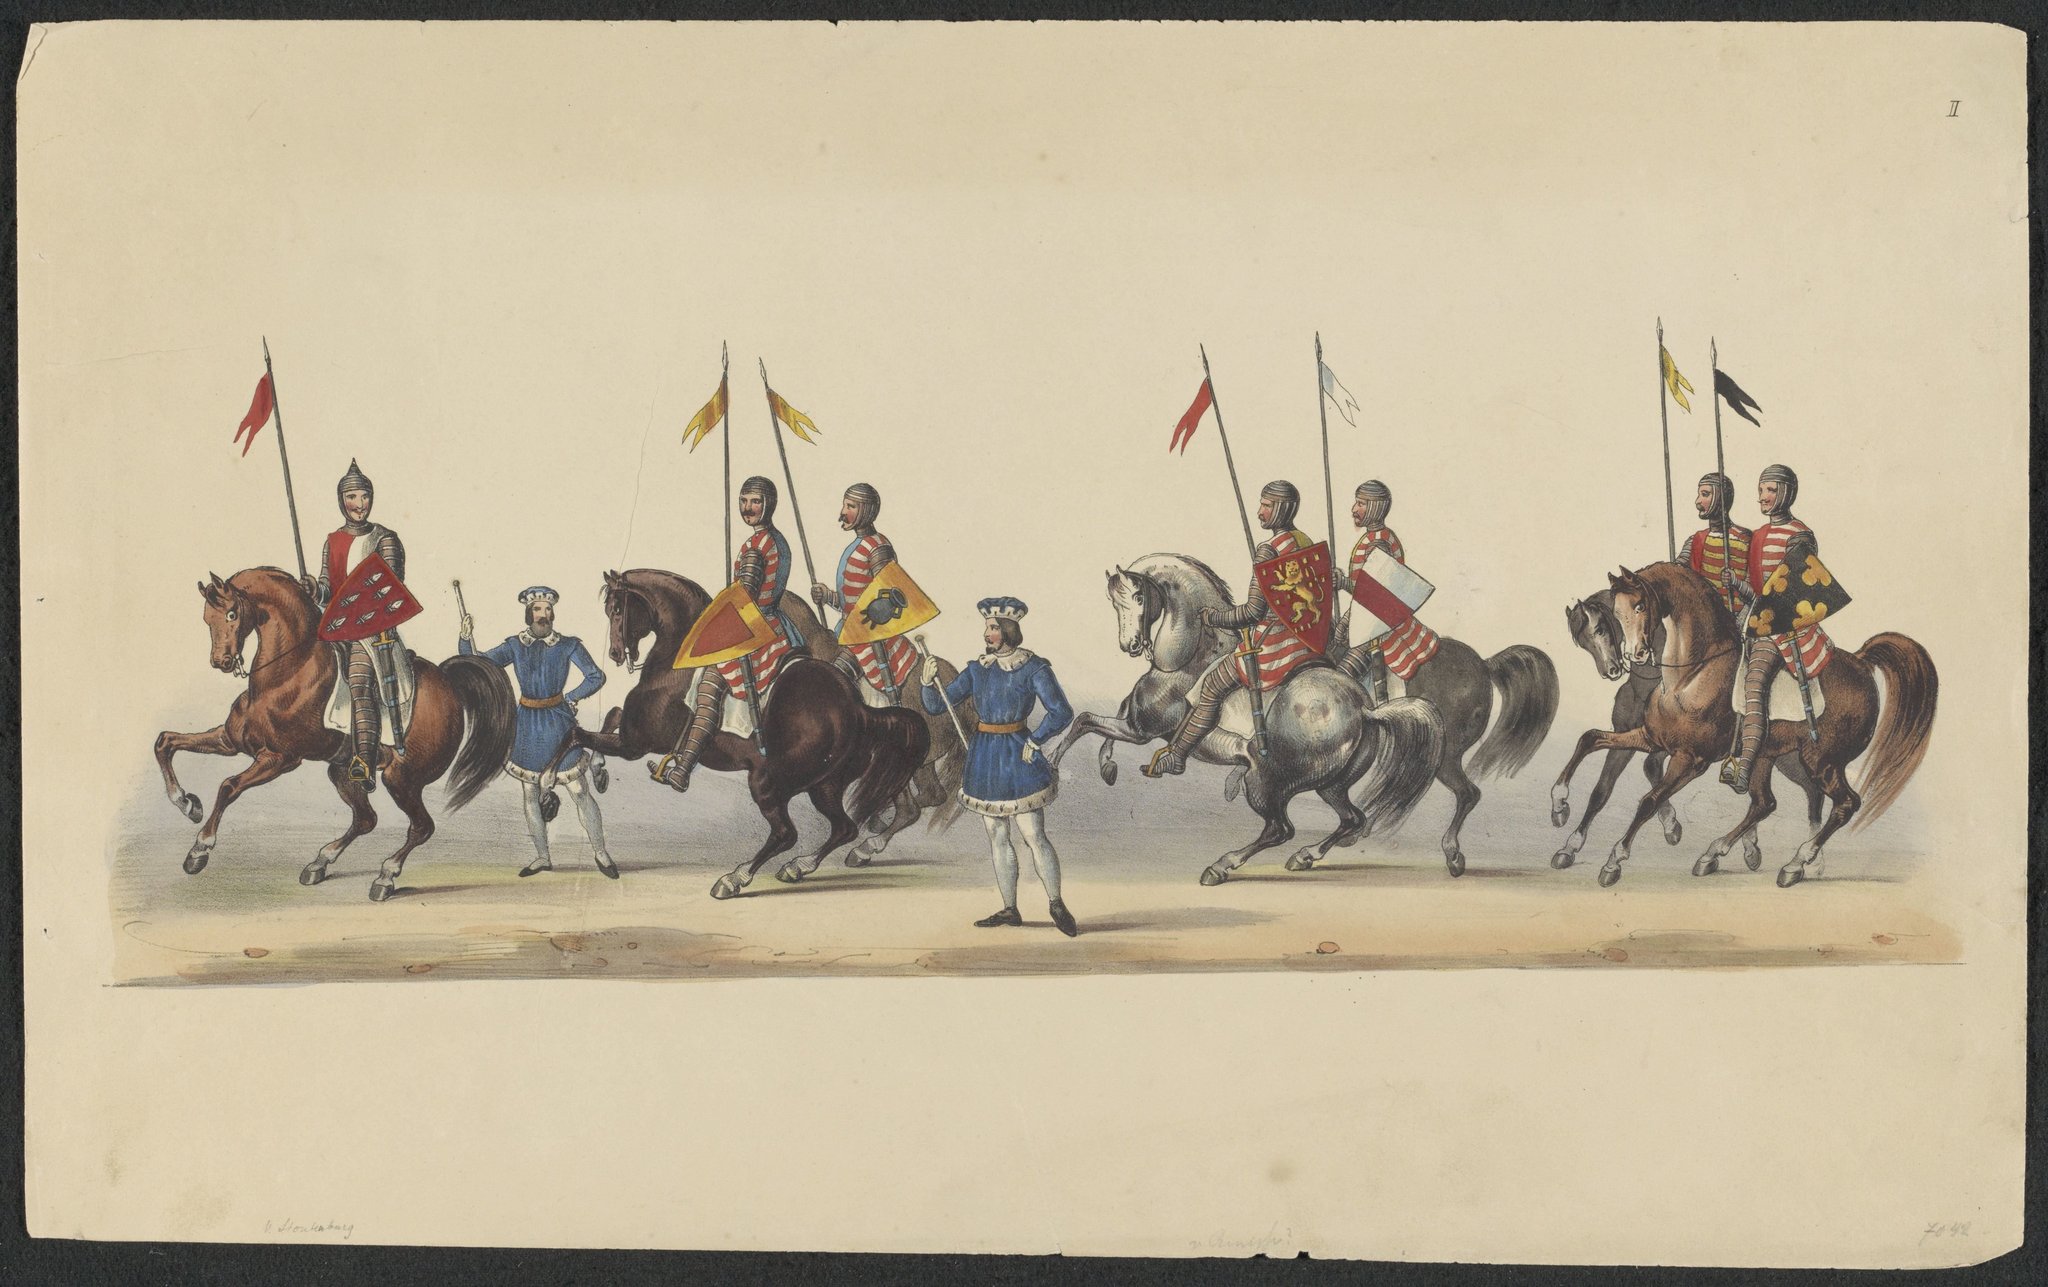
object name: print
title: Gekostumeerde optocht van 1841: zeven ruiters en twee herauten (blad I)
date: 1841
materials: paper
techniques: hand coloring, lithograph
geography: leiden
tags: students' pageant, costumes used in pageants, utrecht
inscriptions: collector's mark: Lugt 2228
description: Zeven ruiters in wapenrusting en twee herauten te voet. Blad genummerd I in de serie van achttien platen van de historische gekostumeerde optocht voorstellende de ontvangst van graaf Willem II van Holland in Utrecht in 1249. De optocht gehouden door de studenten van de Universiteit van Utrecht op 2 juni 1841 ter gelegenheid van de viering van het vijfentwintigjarige herstel van de Hogeschool.